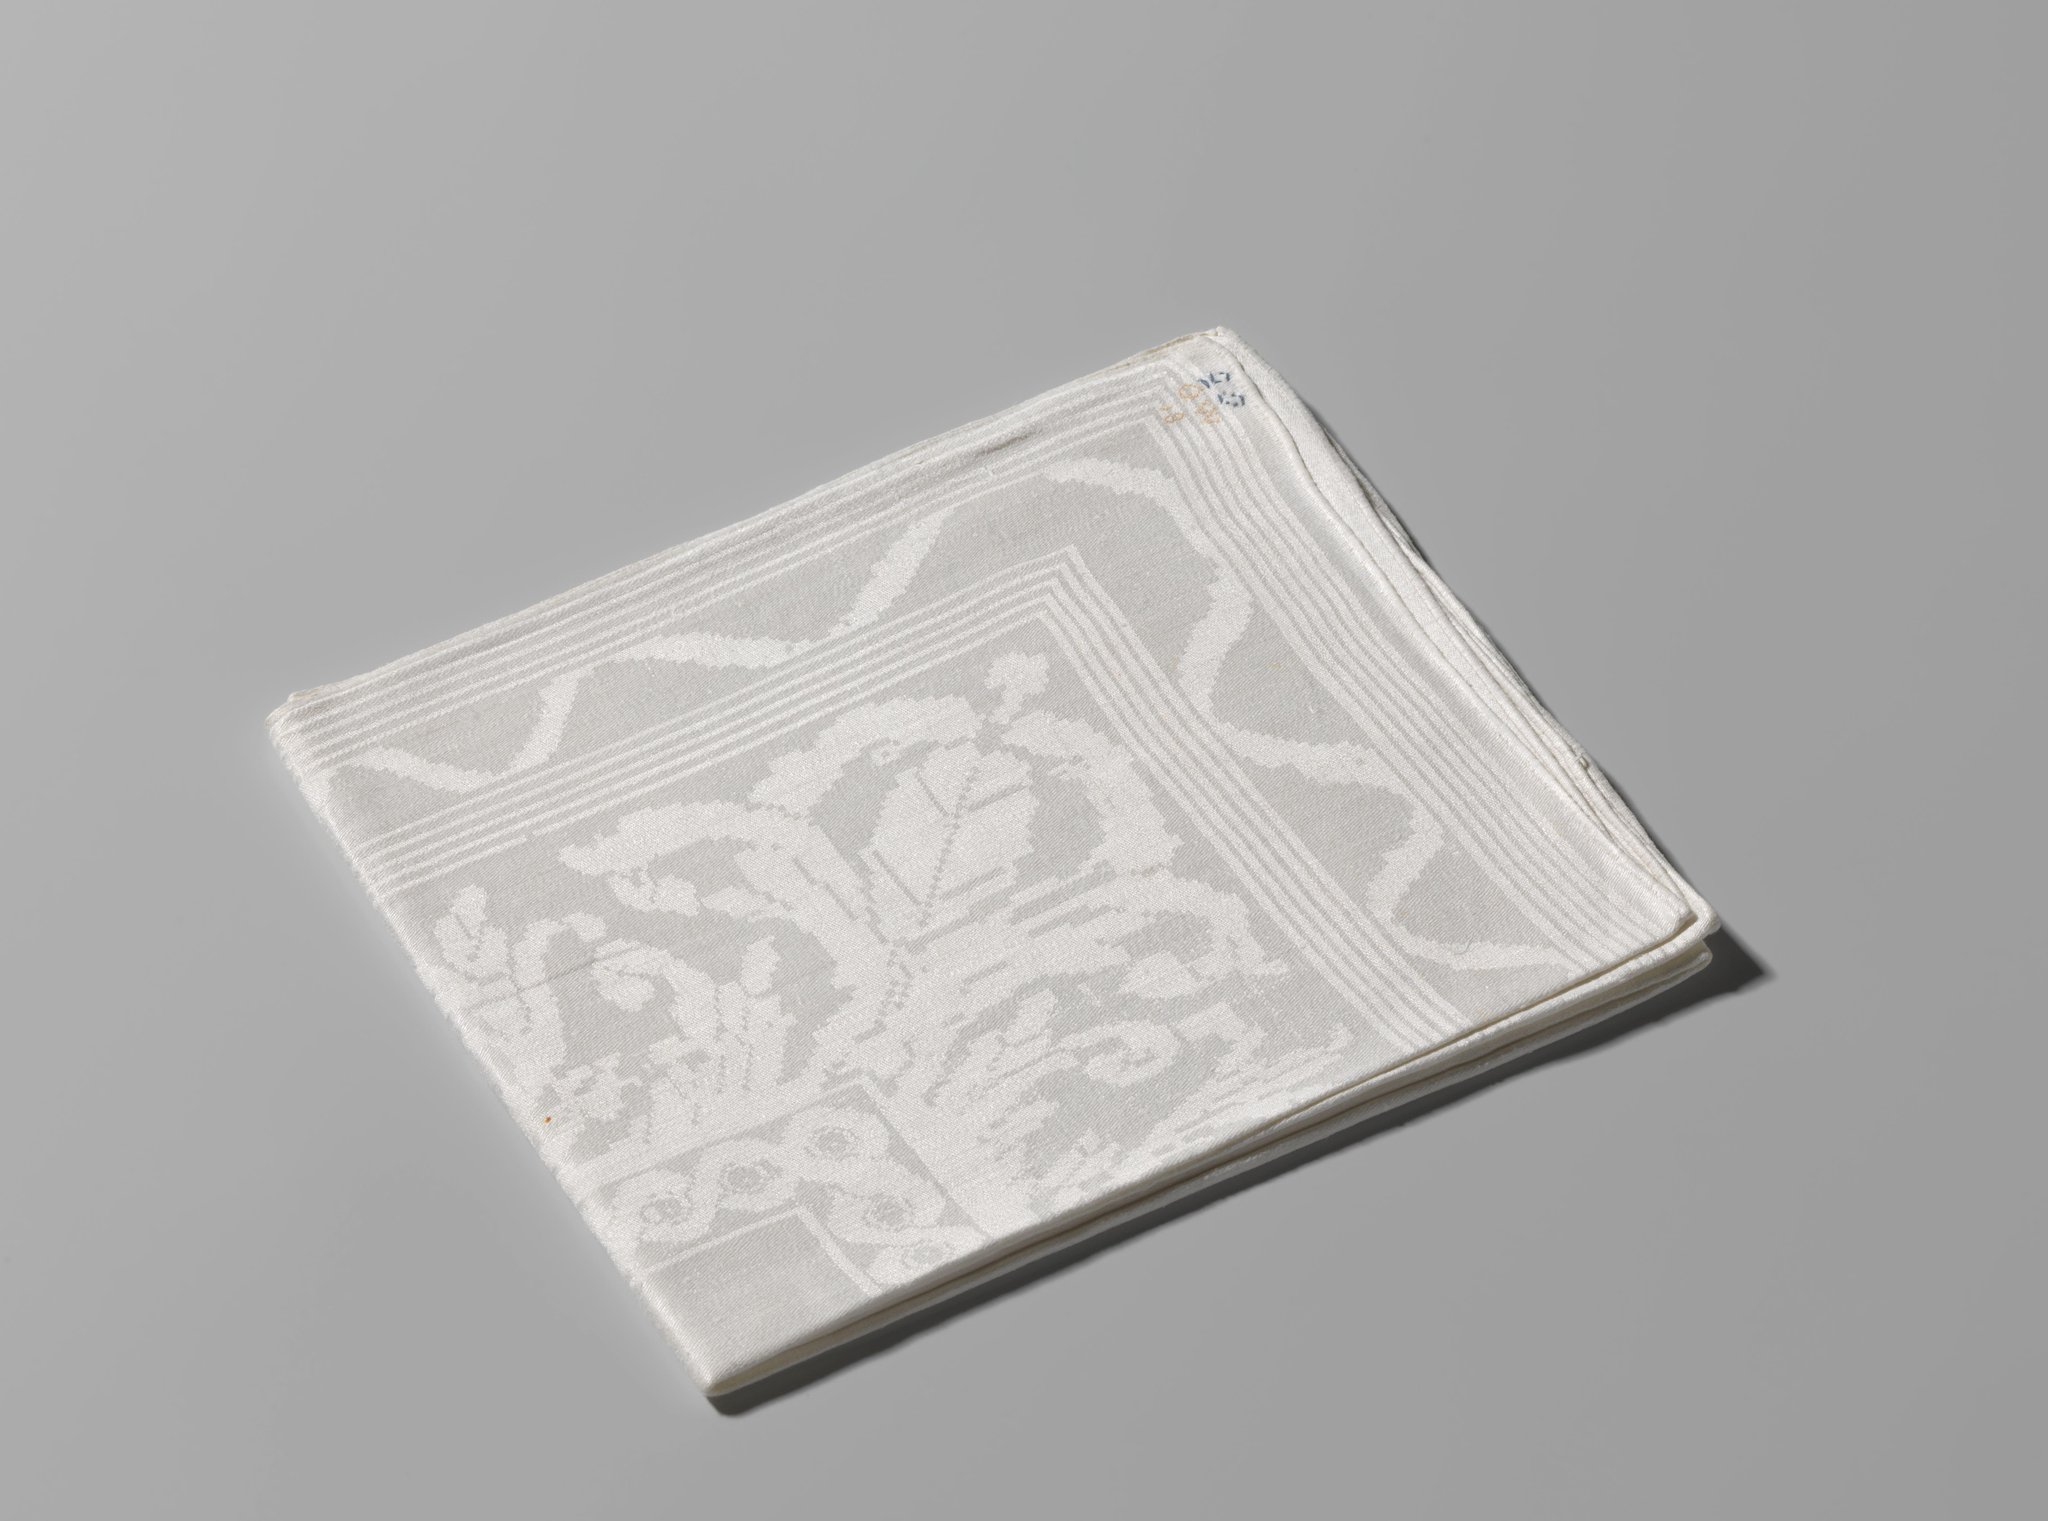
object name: napkin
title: Servet van damast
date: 1757-1800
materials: linen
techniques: damask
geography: northern netherlands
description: Damasten servet met het wapen Quack, gemerkt QW 18.